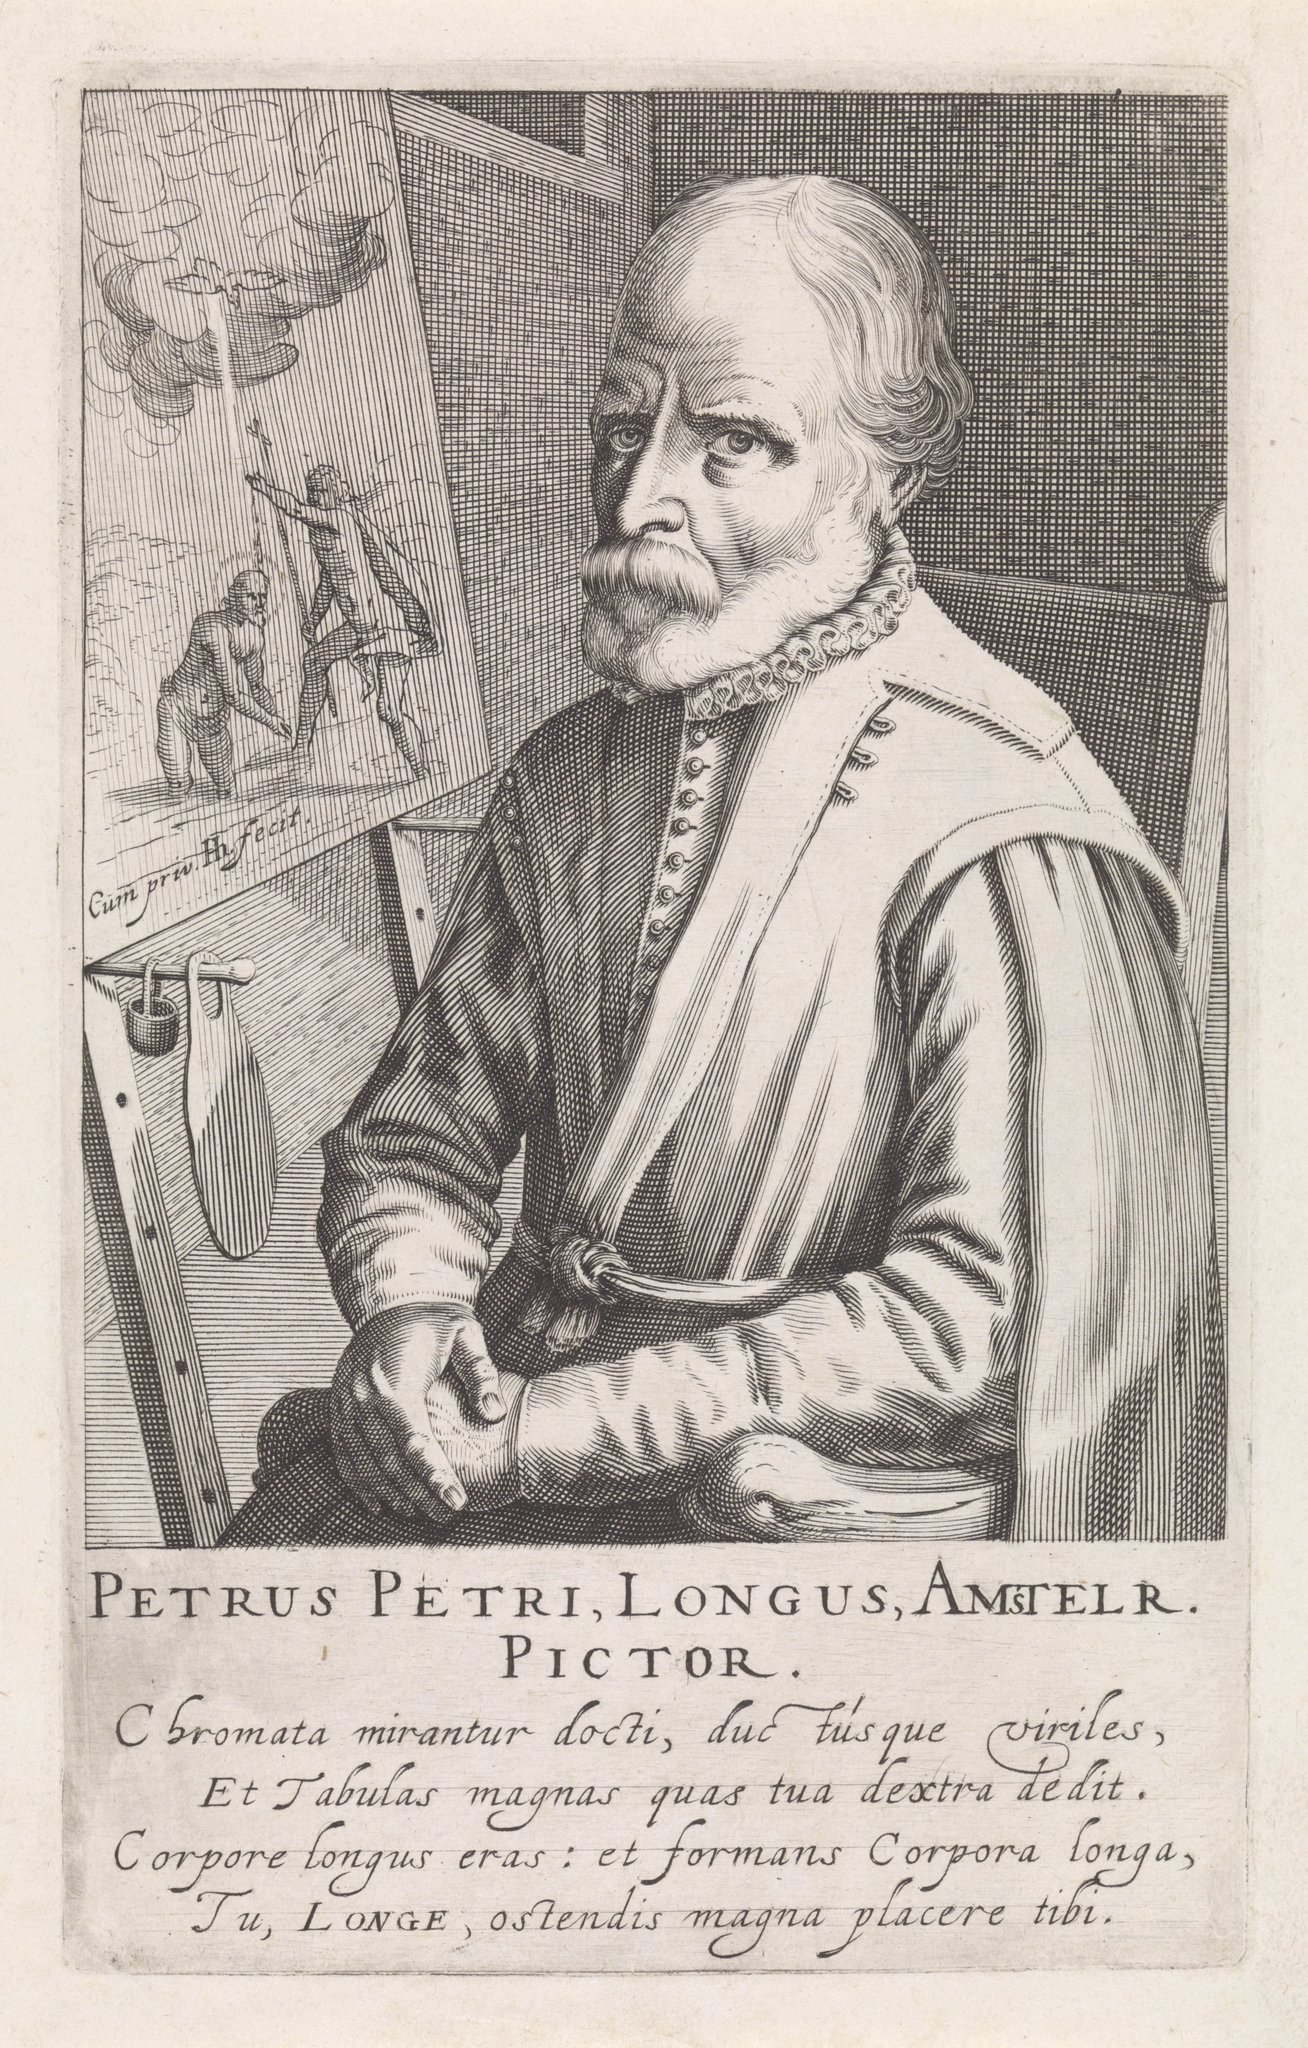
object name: print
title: Pictorum aliquot celebrium praecipuae Germaniae Inferioris effigies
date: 1610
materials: paper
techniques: engraving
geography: the hague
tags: amsterdam, pieter pietersz. (i), historical persons, portrait, self-portrait of painter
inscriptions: collector's mark: Lugt 2228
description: Portret ten halven lijve naar links van Pieter Aertsen. Onder het portret zijn naam en vier regels in het Latijn. Prent uit deel 2 van de serie Pictorum Aliquot Celebrium Praecipuae Germaniae Inferioris Effigies. Serie van 72 kunstenaarsportretten vervaardigd door Hendrick Hondius I, Simon Frisius, Andries Jacobsz. Stock en Robert de Baudous.